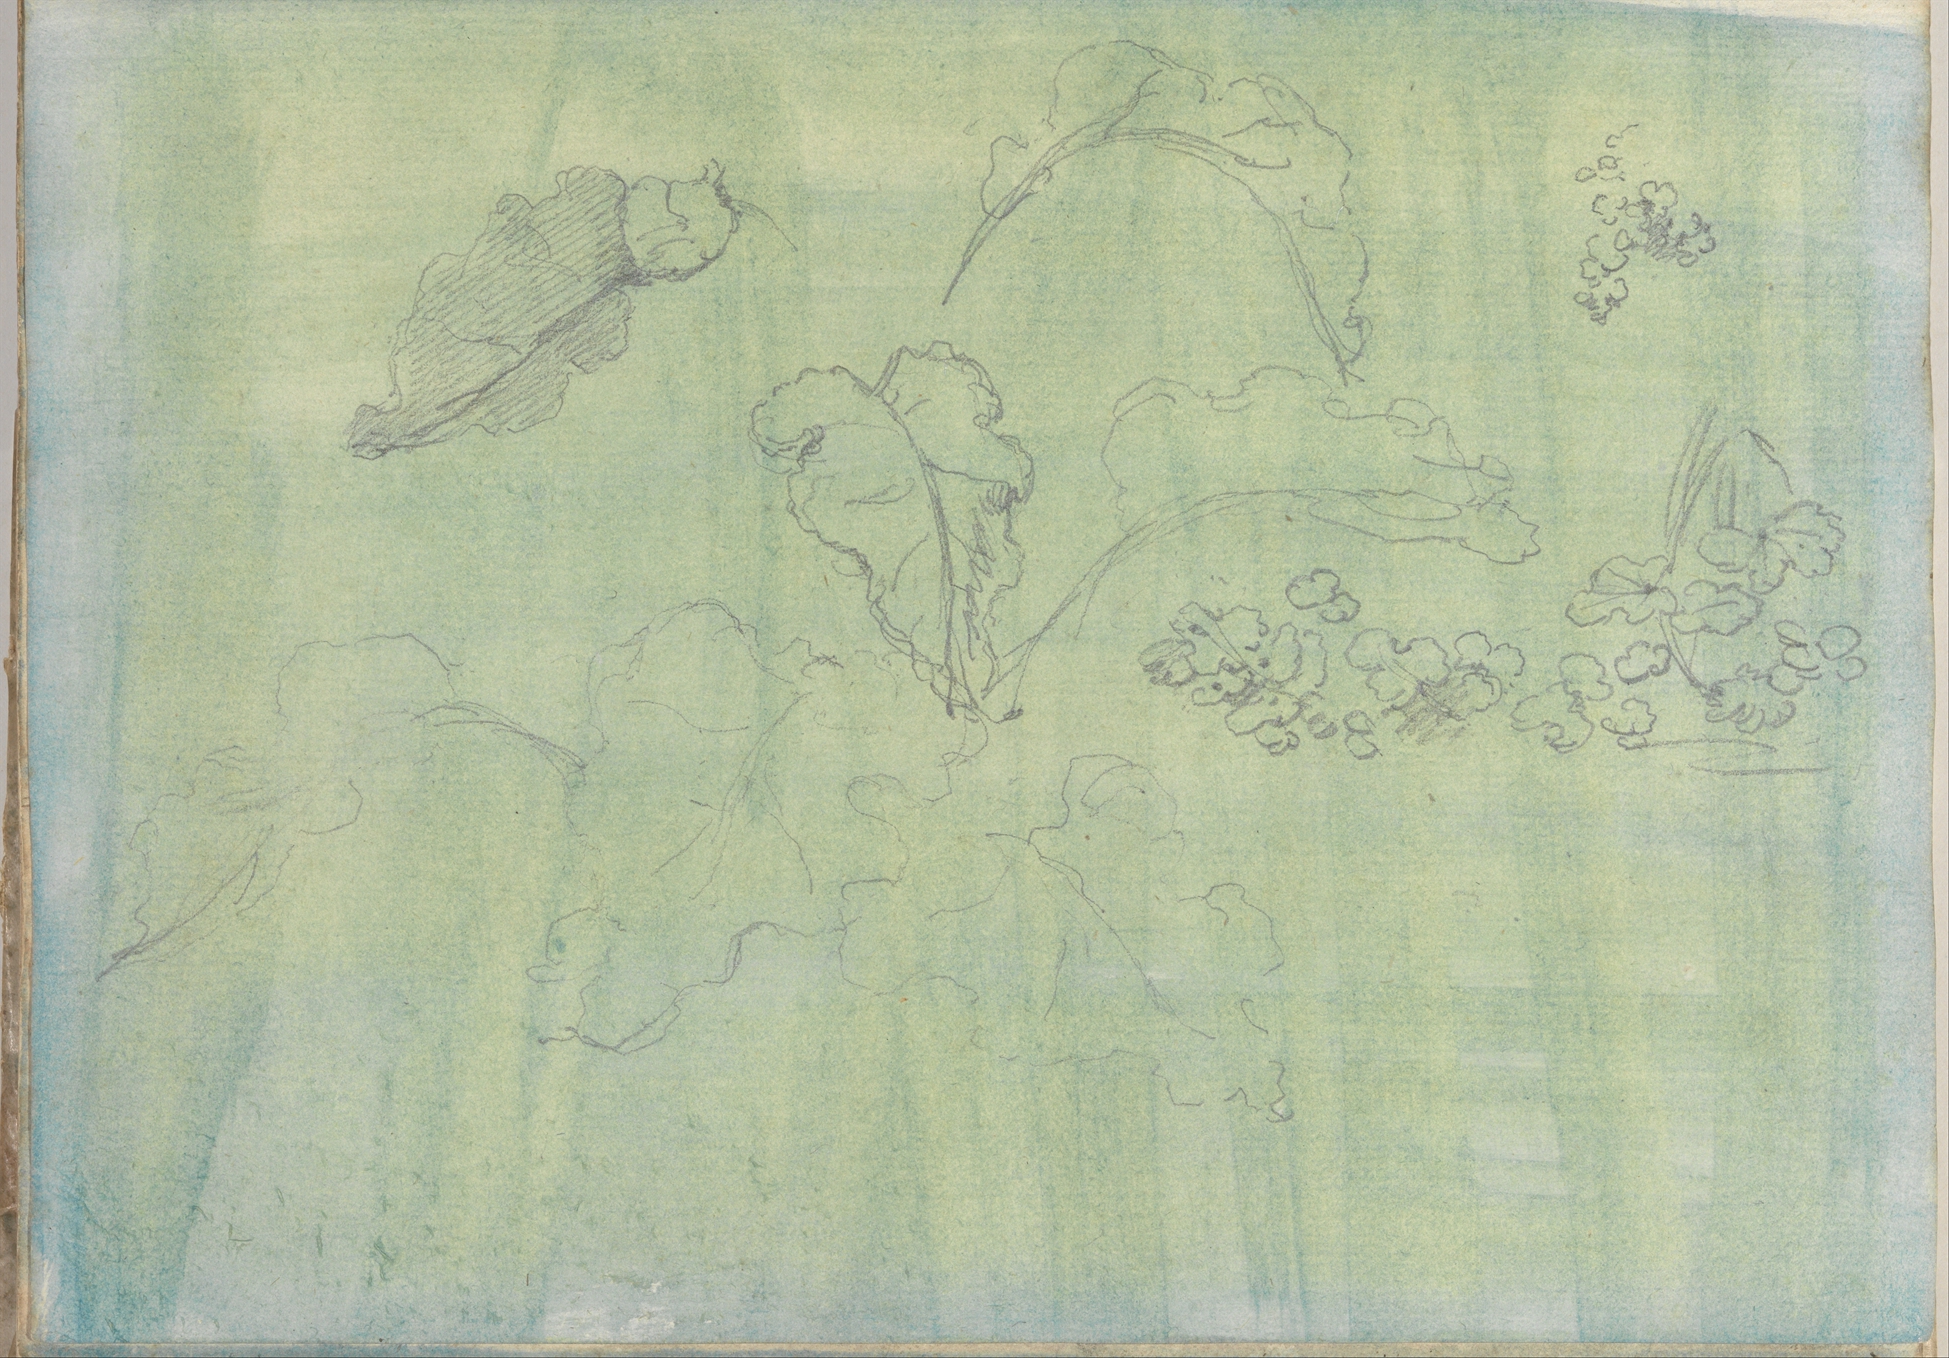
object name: drawing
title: Carved panel and border ornament (recto). Sketches of leaves (verso) (Smaller Italian sketchbook, leaf 21)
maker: joseph wright (wright of derby)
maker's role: artist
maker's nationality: british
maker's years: 1734-1797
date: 1774-1775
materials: graphite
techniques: brush, wash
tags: leaves